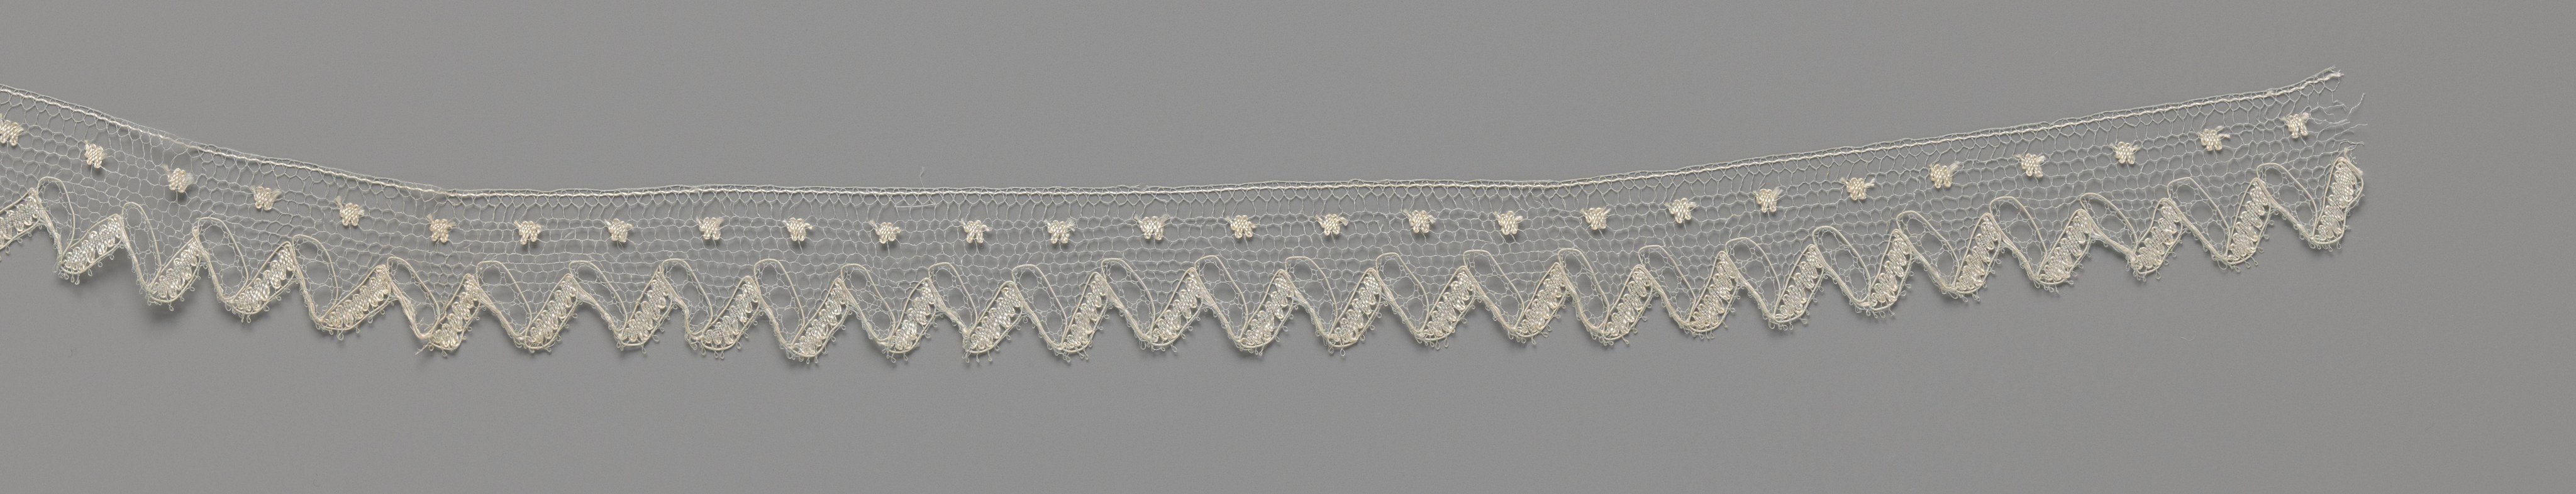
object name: strip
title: Strook kloskant met zigzag-rand en één rij moesjes in een blauwe tulegrond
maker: Anonymous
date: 1850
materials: silk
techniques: lace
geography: le puy-en-velay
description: Strook naturelkleurige en blauw gekleurde kloskant: blonde van Caen. Onder één rij moesjes loopt langs de onderrand van de strook een zigzag-rand van omgekeerde v-motieven. De ene poot van elk v-motief is geklost in linnenslag met een dikkere glimmende contourdraad en de andere poot bestaat alleen uit een contourdraad waarbinnen een siergrond is toegepast, een rozengrond. De traliegrond daarboven waarin de moesjes zijn gewerkt betreft een tulegrond en is geklost met een blauwe draad. De bovenzijde van de strook is recht afgewerkt. De schulpenrand met driehoekige schulpen wordt gevormd door de zigzag en is afgewerkt met picots.